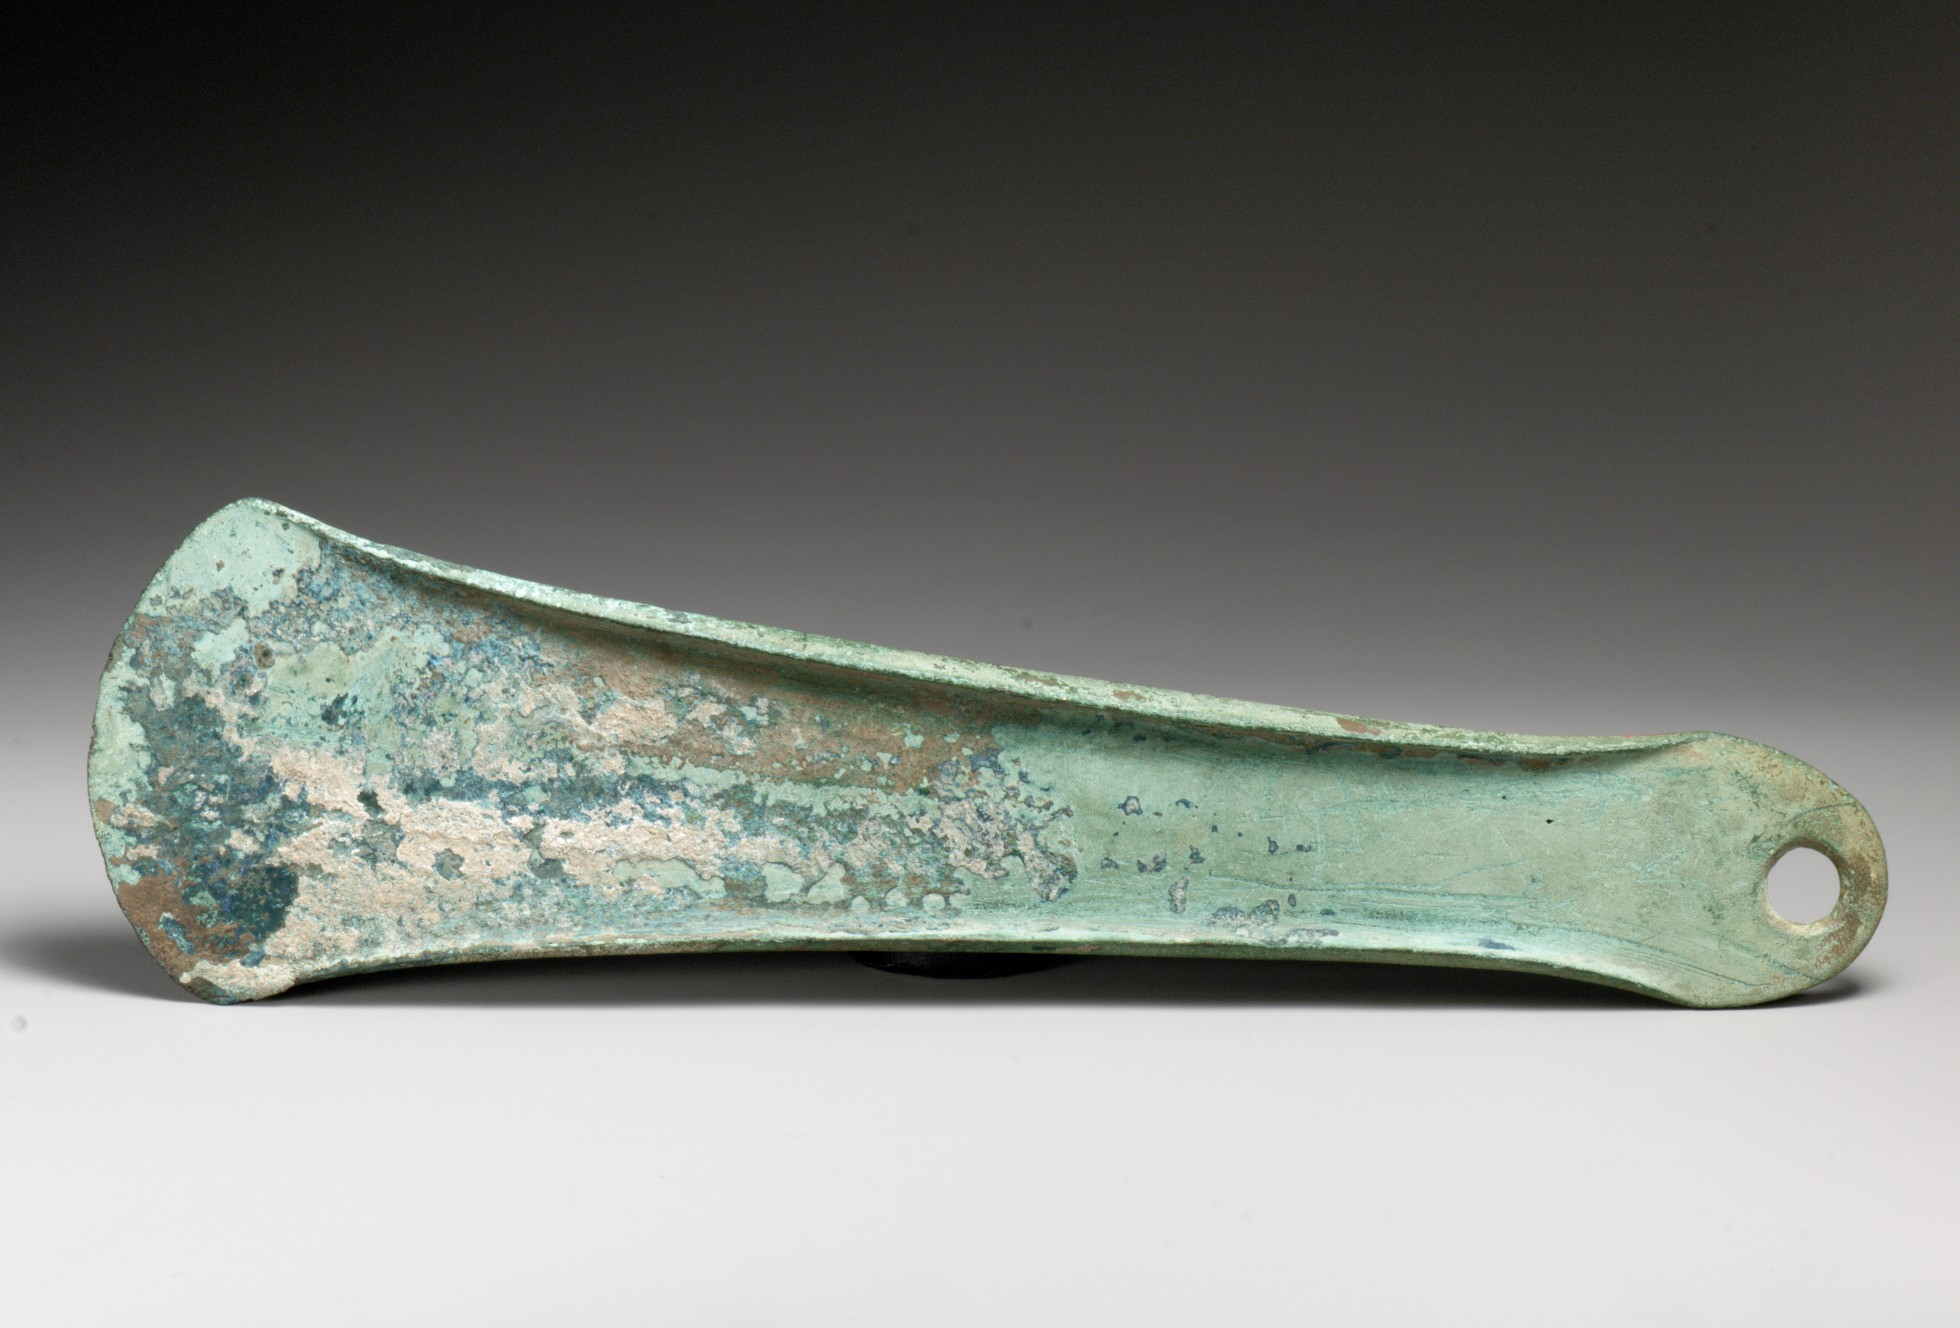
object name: axehead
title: Bronze flanged axe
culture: helladic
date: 2000-1001 BCE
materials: bronze